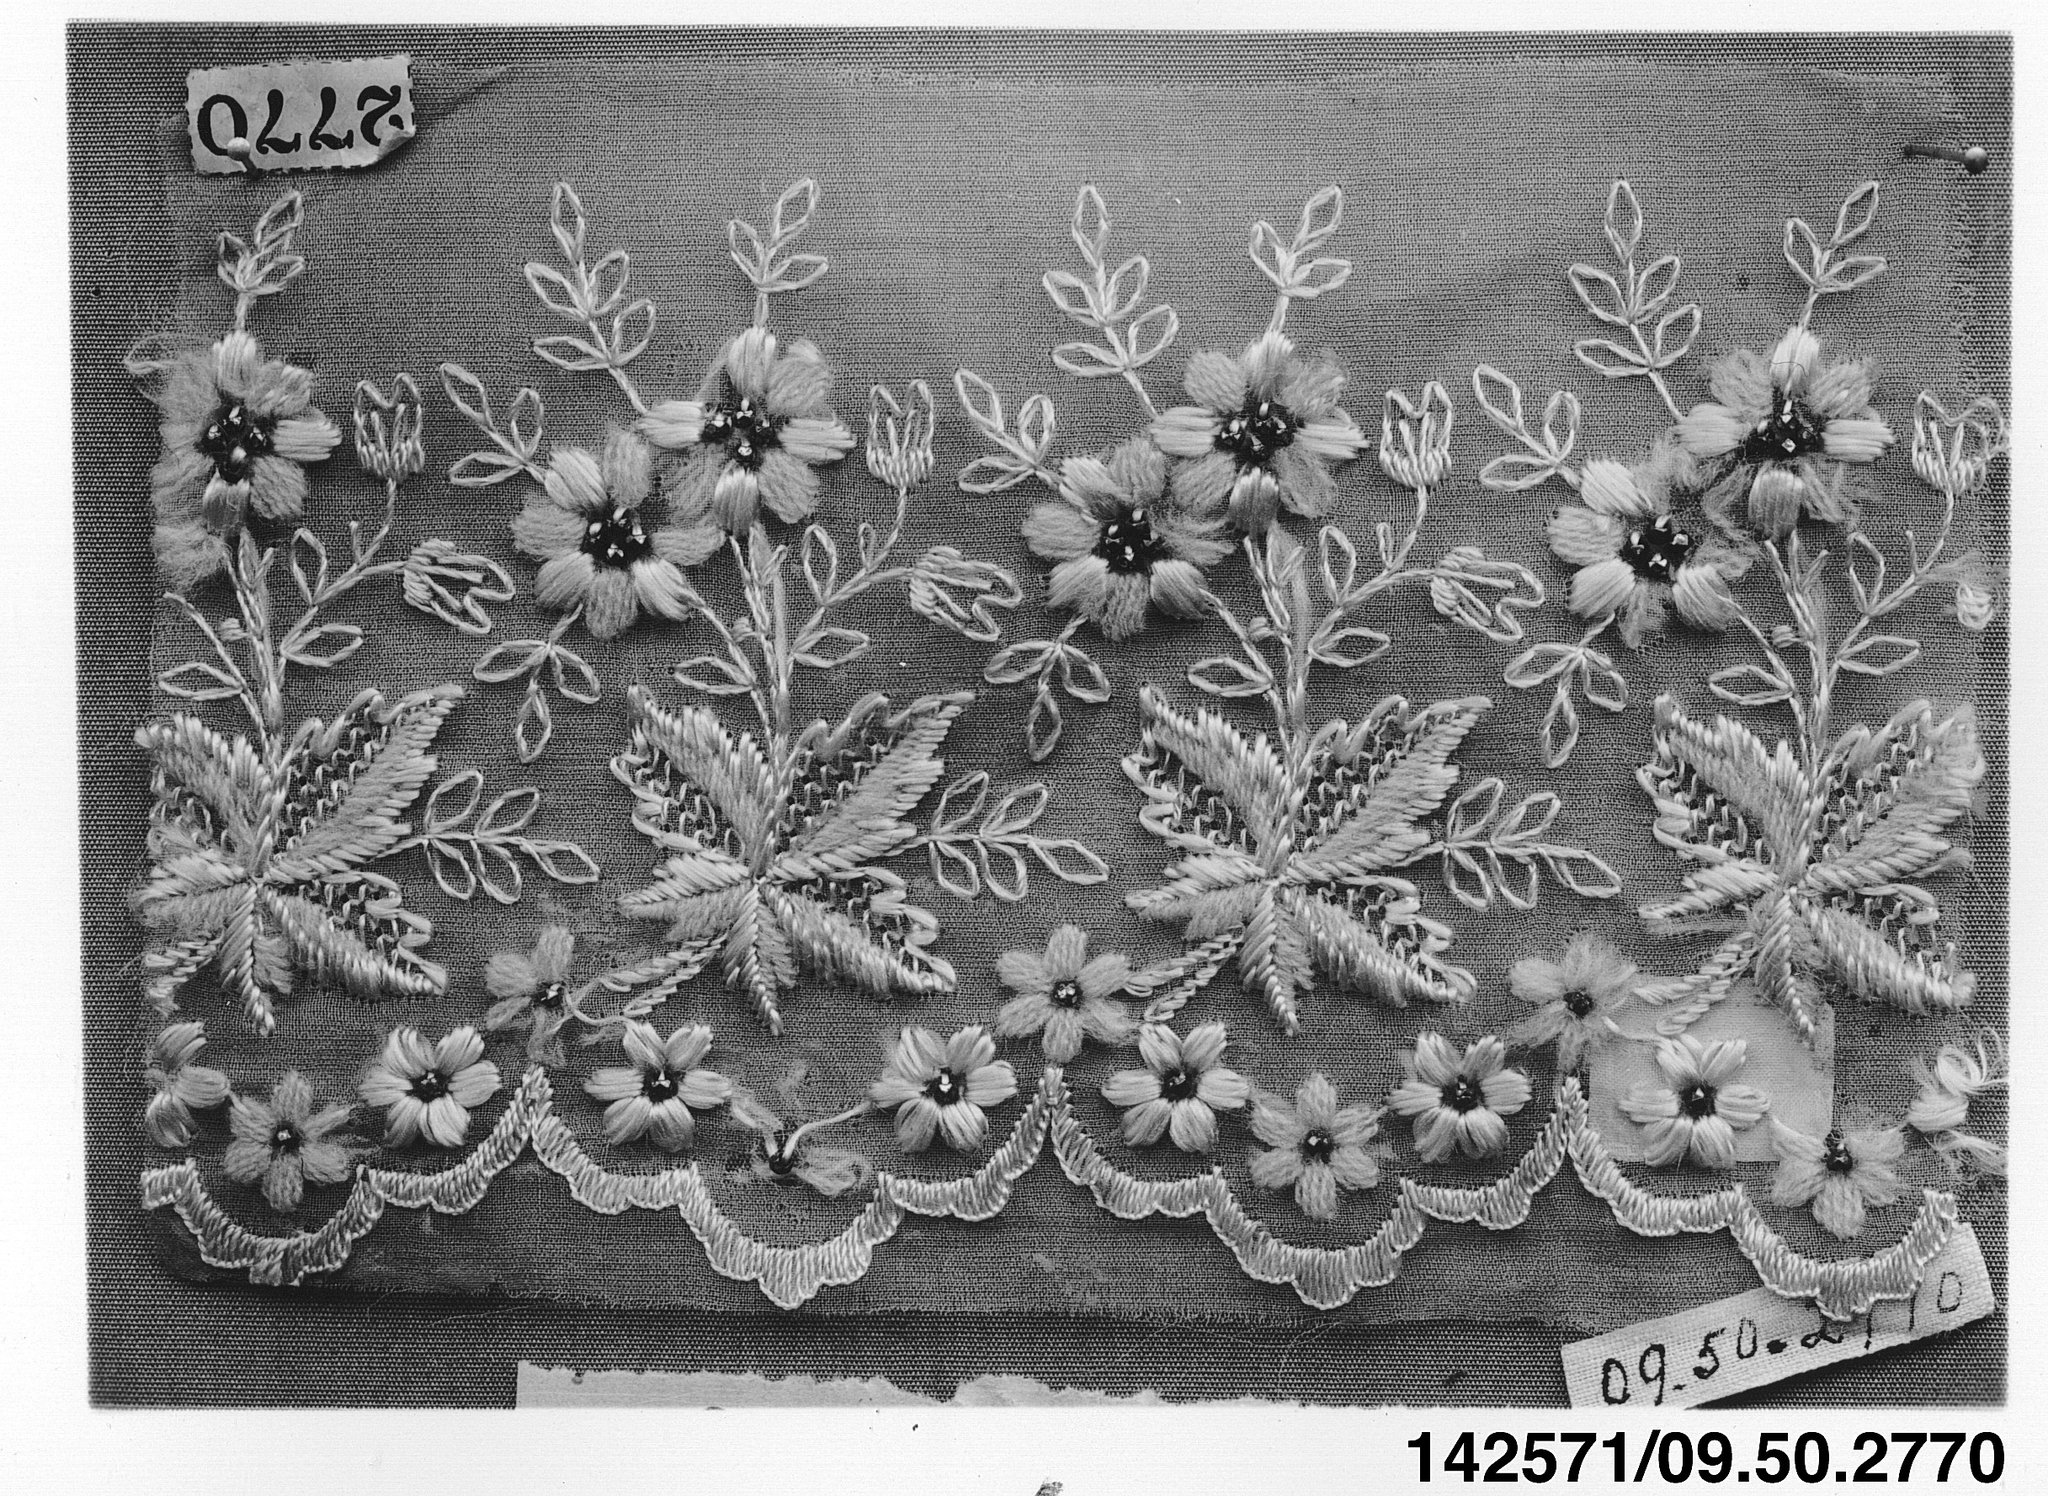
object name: border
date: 1801-1900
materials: silk, wool